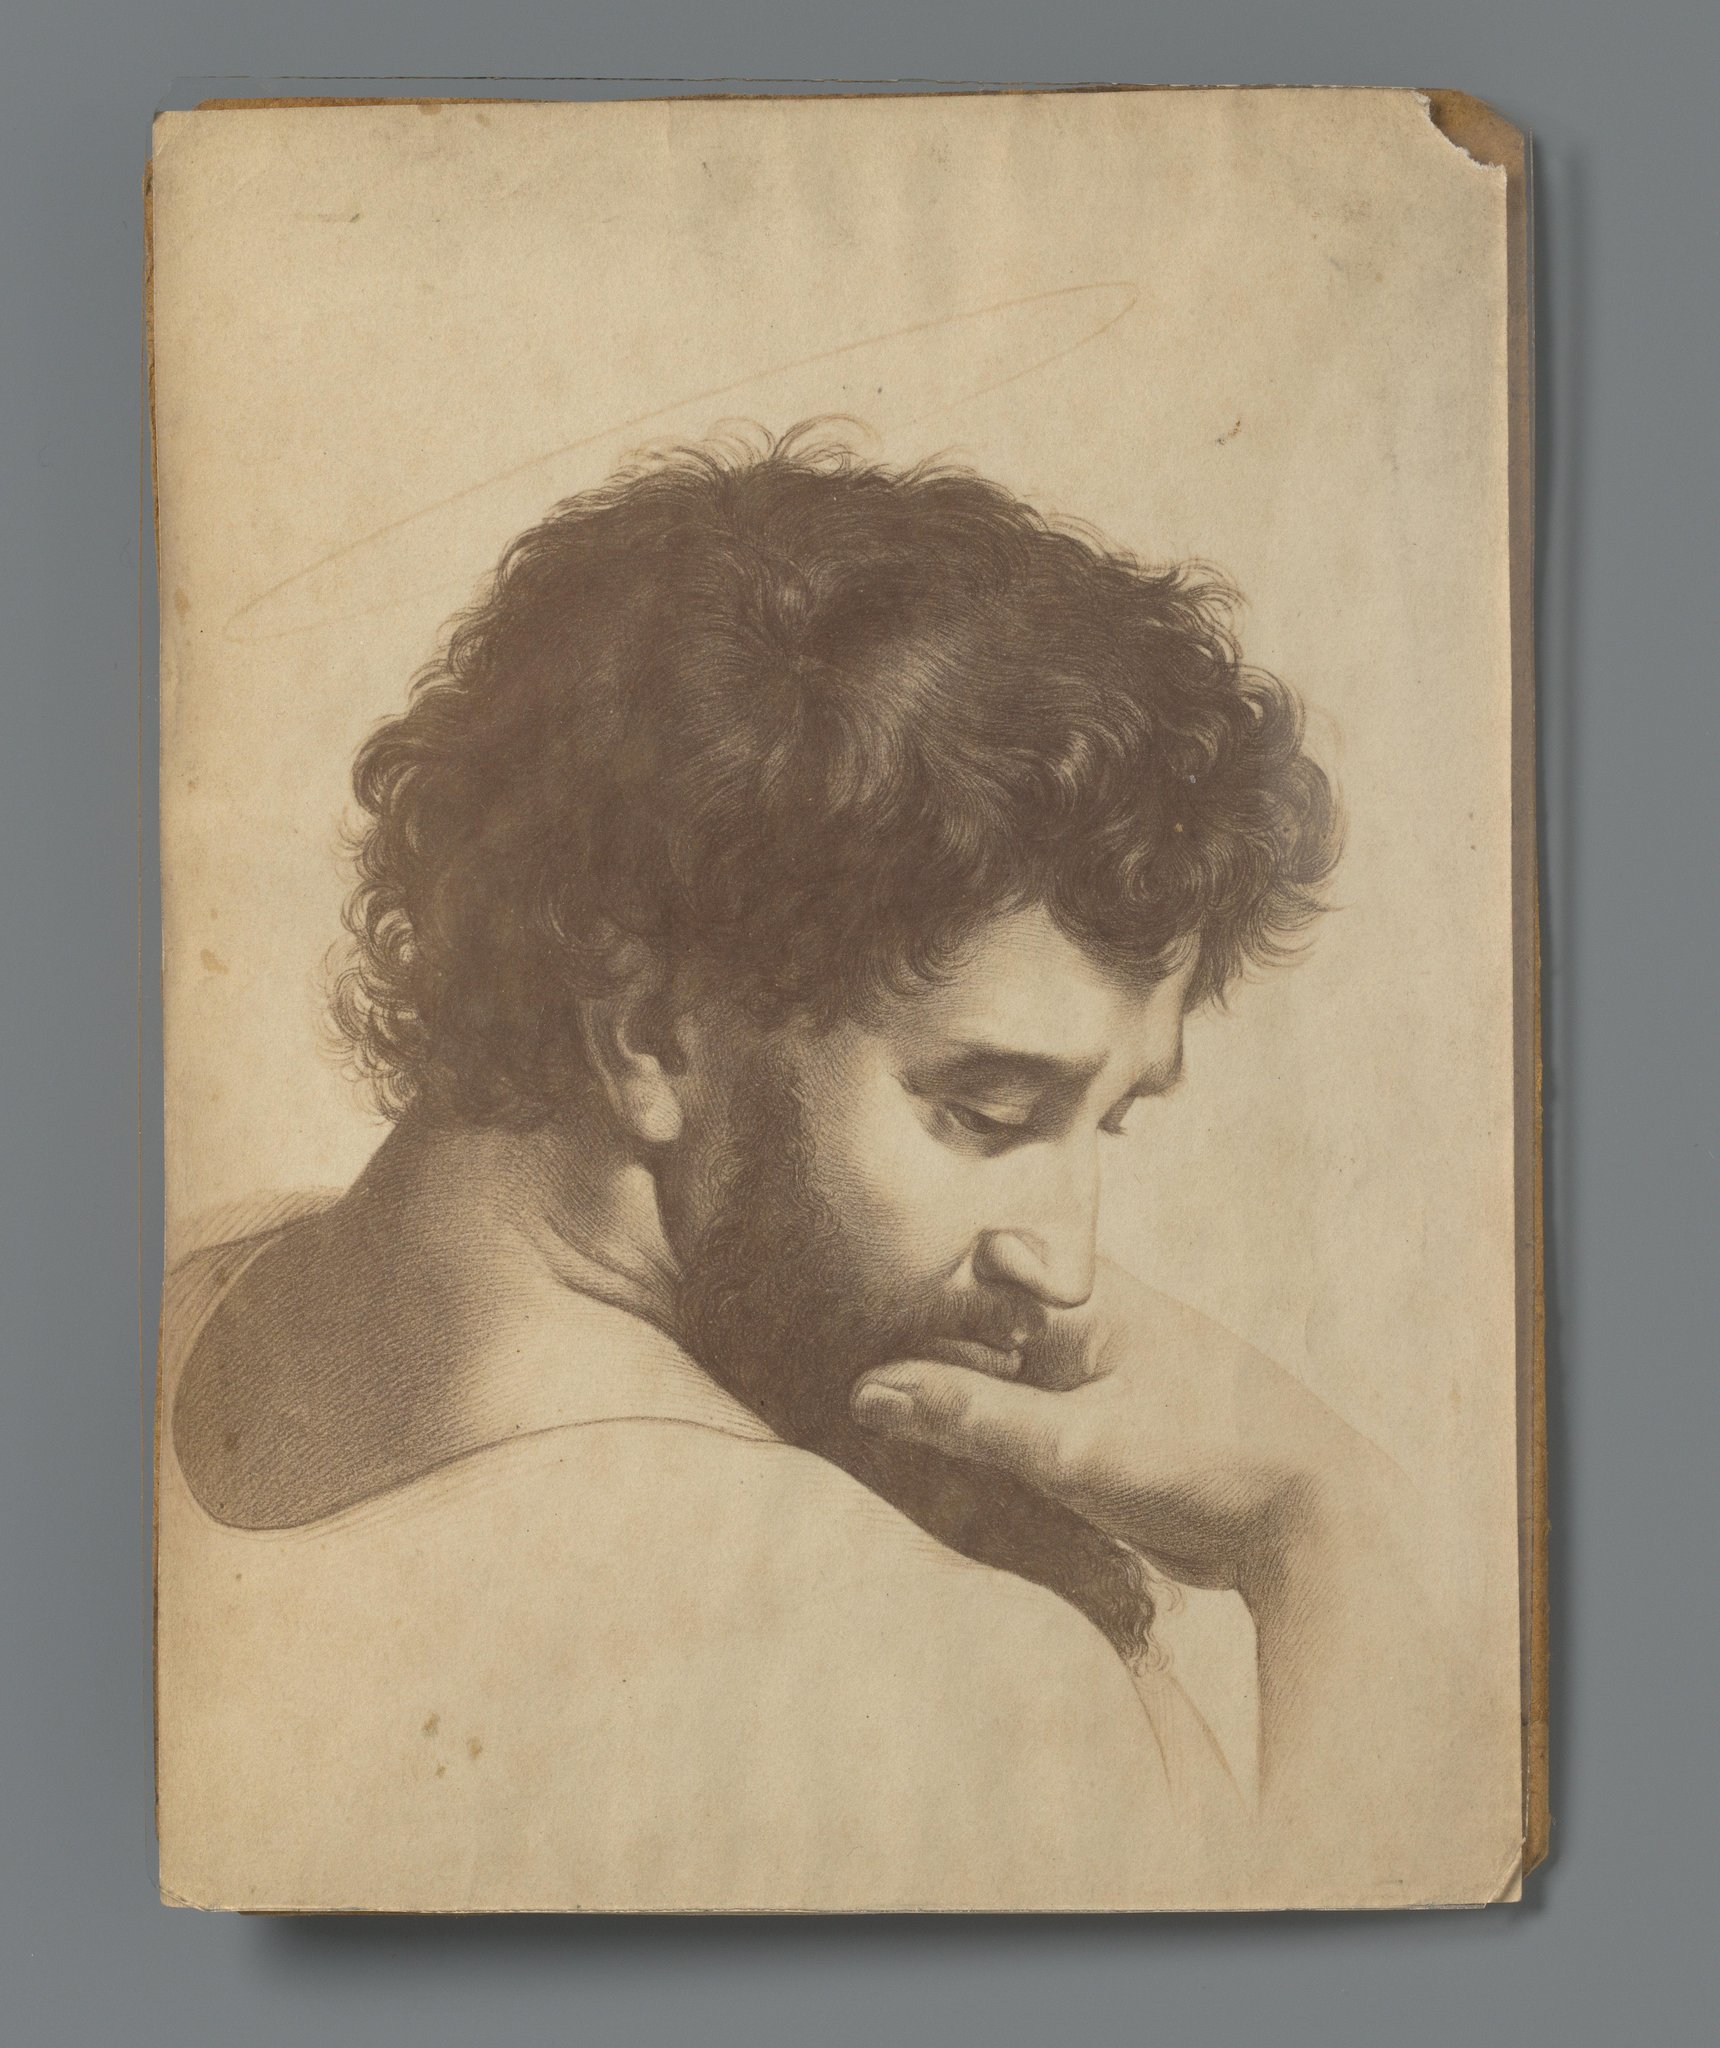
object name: reproduction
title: Fotoreproductie van een prent van Paulus naar ontwerp van Rafaël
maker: Anonymous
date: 1880-1910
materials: cardboard, glass, paper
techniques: albumen print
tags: the apostle paul of tarsus; possible attributes: book, scroll, sword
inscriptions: annotation: ‘Raphael/ tête de st. Paul’